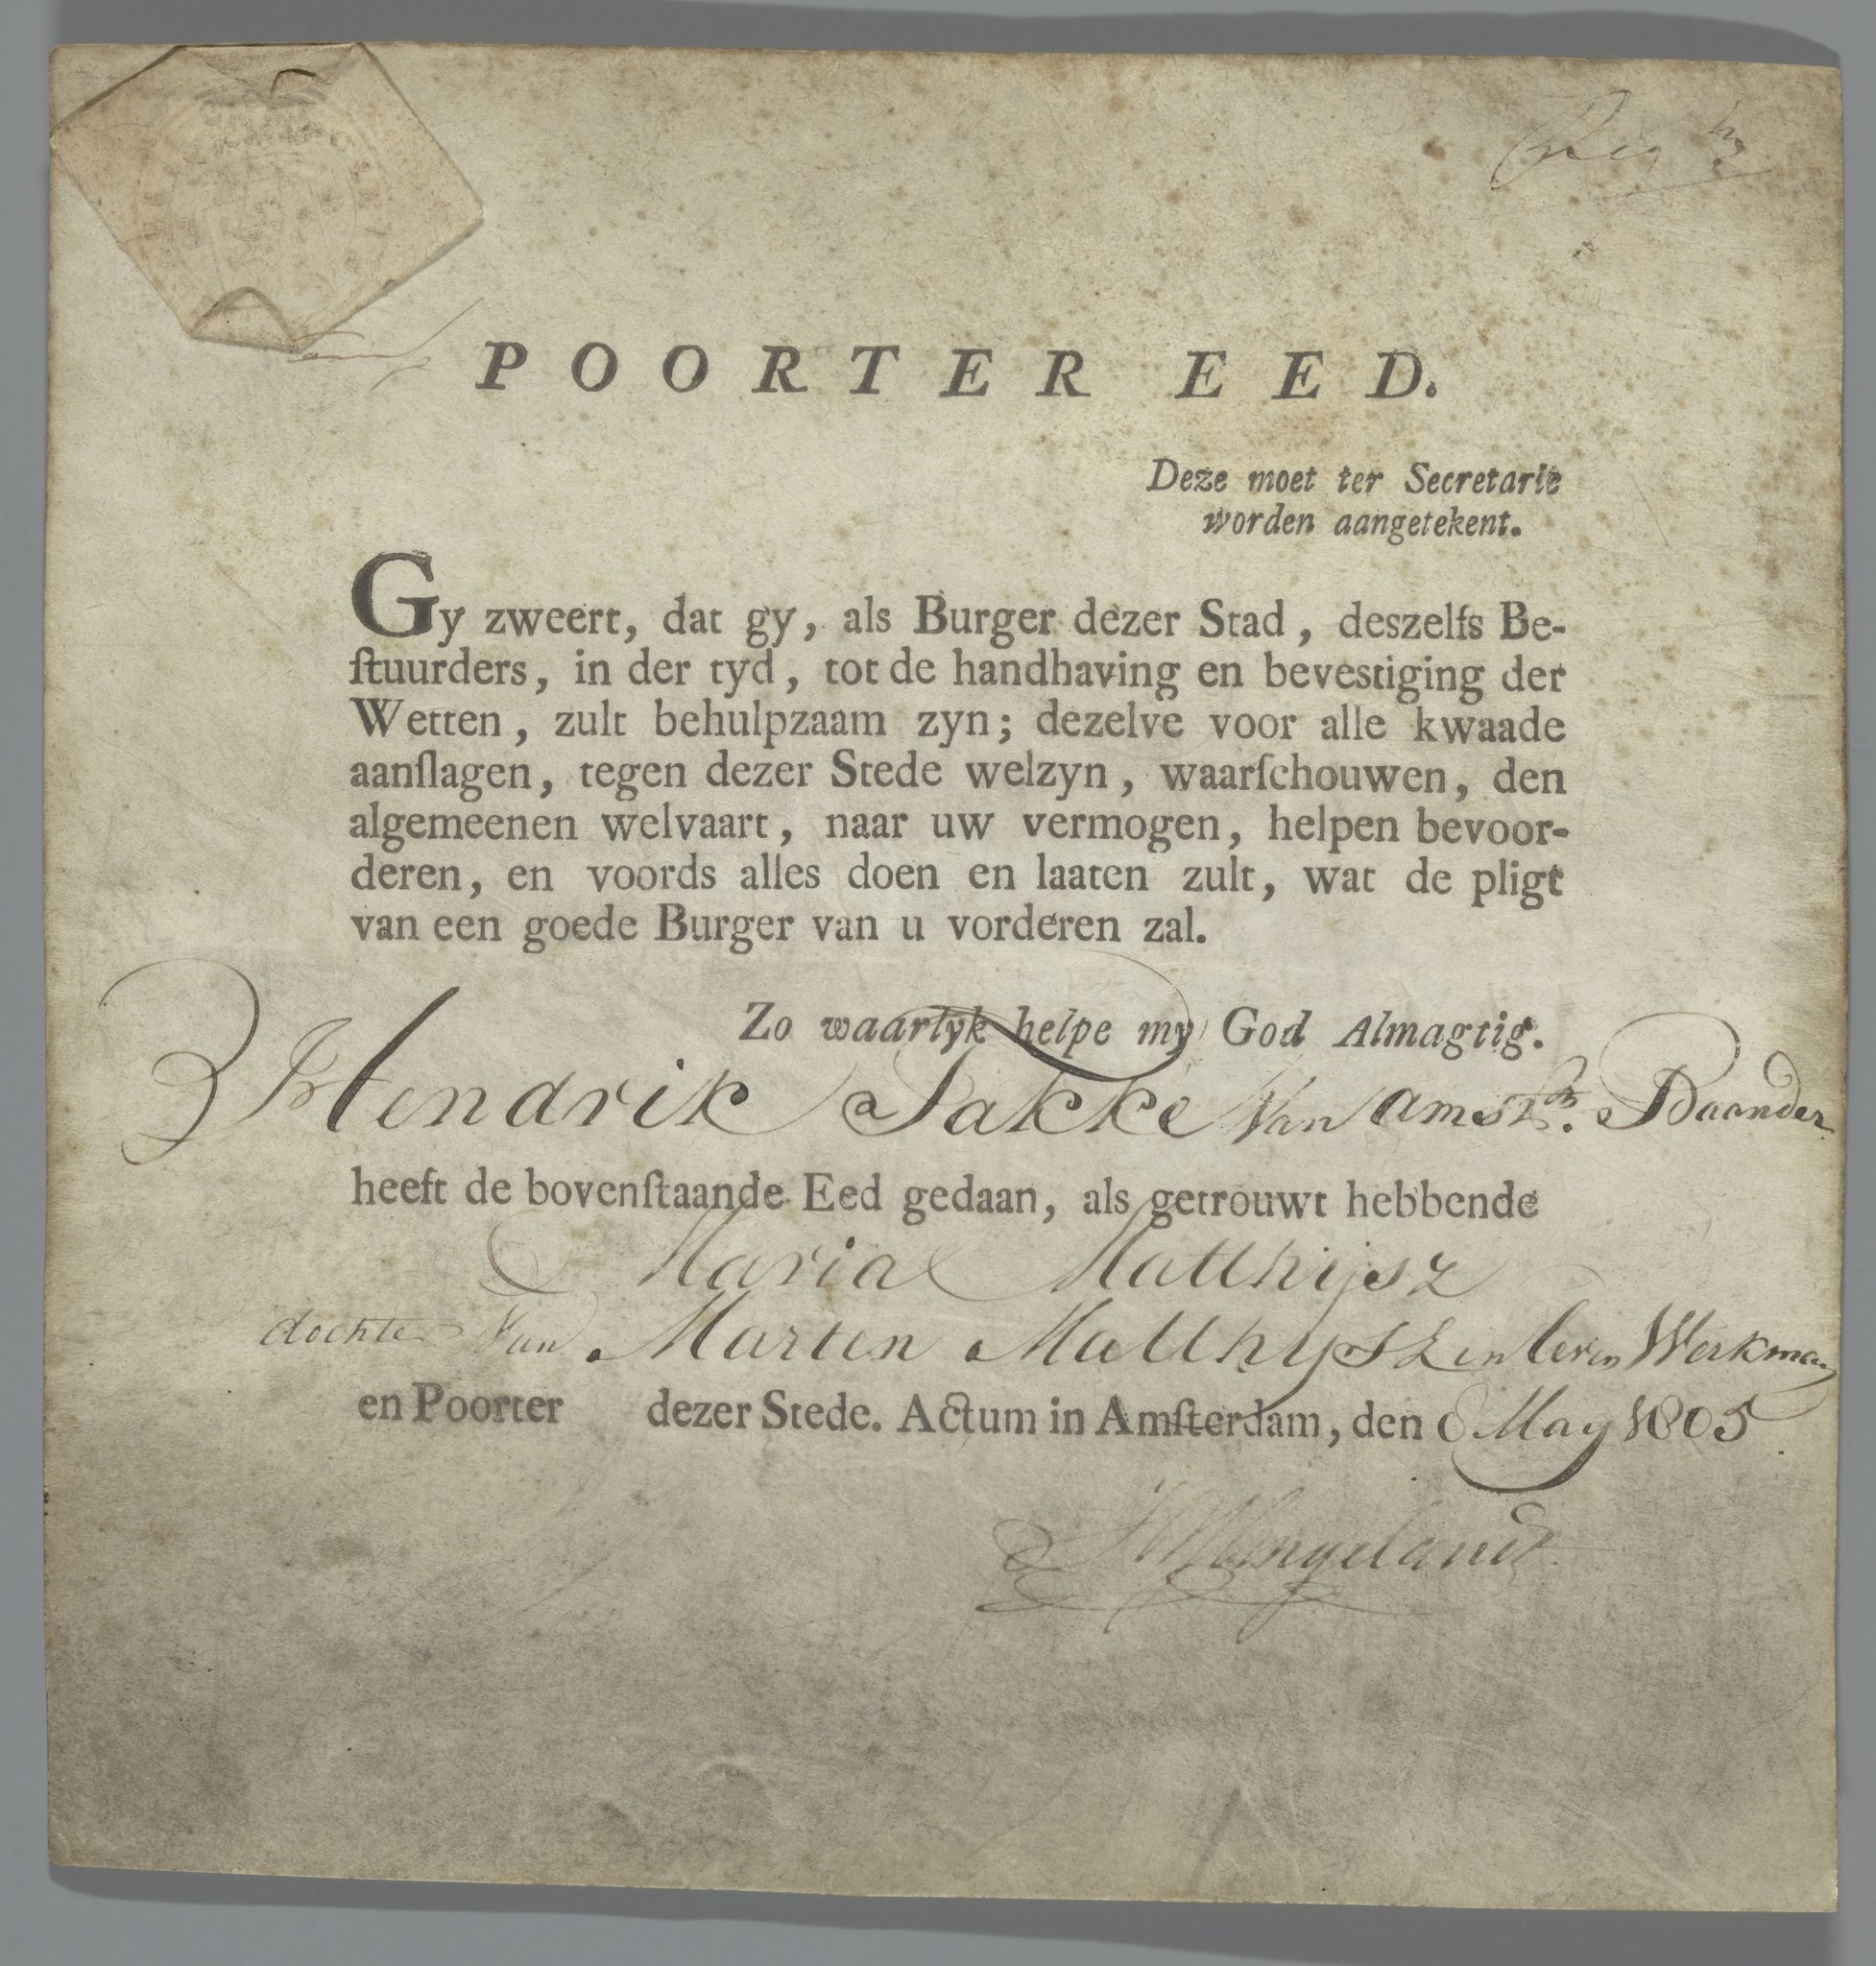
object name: document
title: Poortereed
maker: hieronymus baron van slingelandt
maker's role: baron, secretaris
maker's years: 1762-1829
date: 1805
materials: ink, skin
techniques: printing, writing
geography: amsterdam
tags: h. takke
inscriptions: date